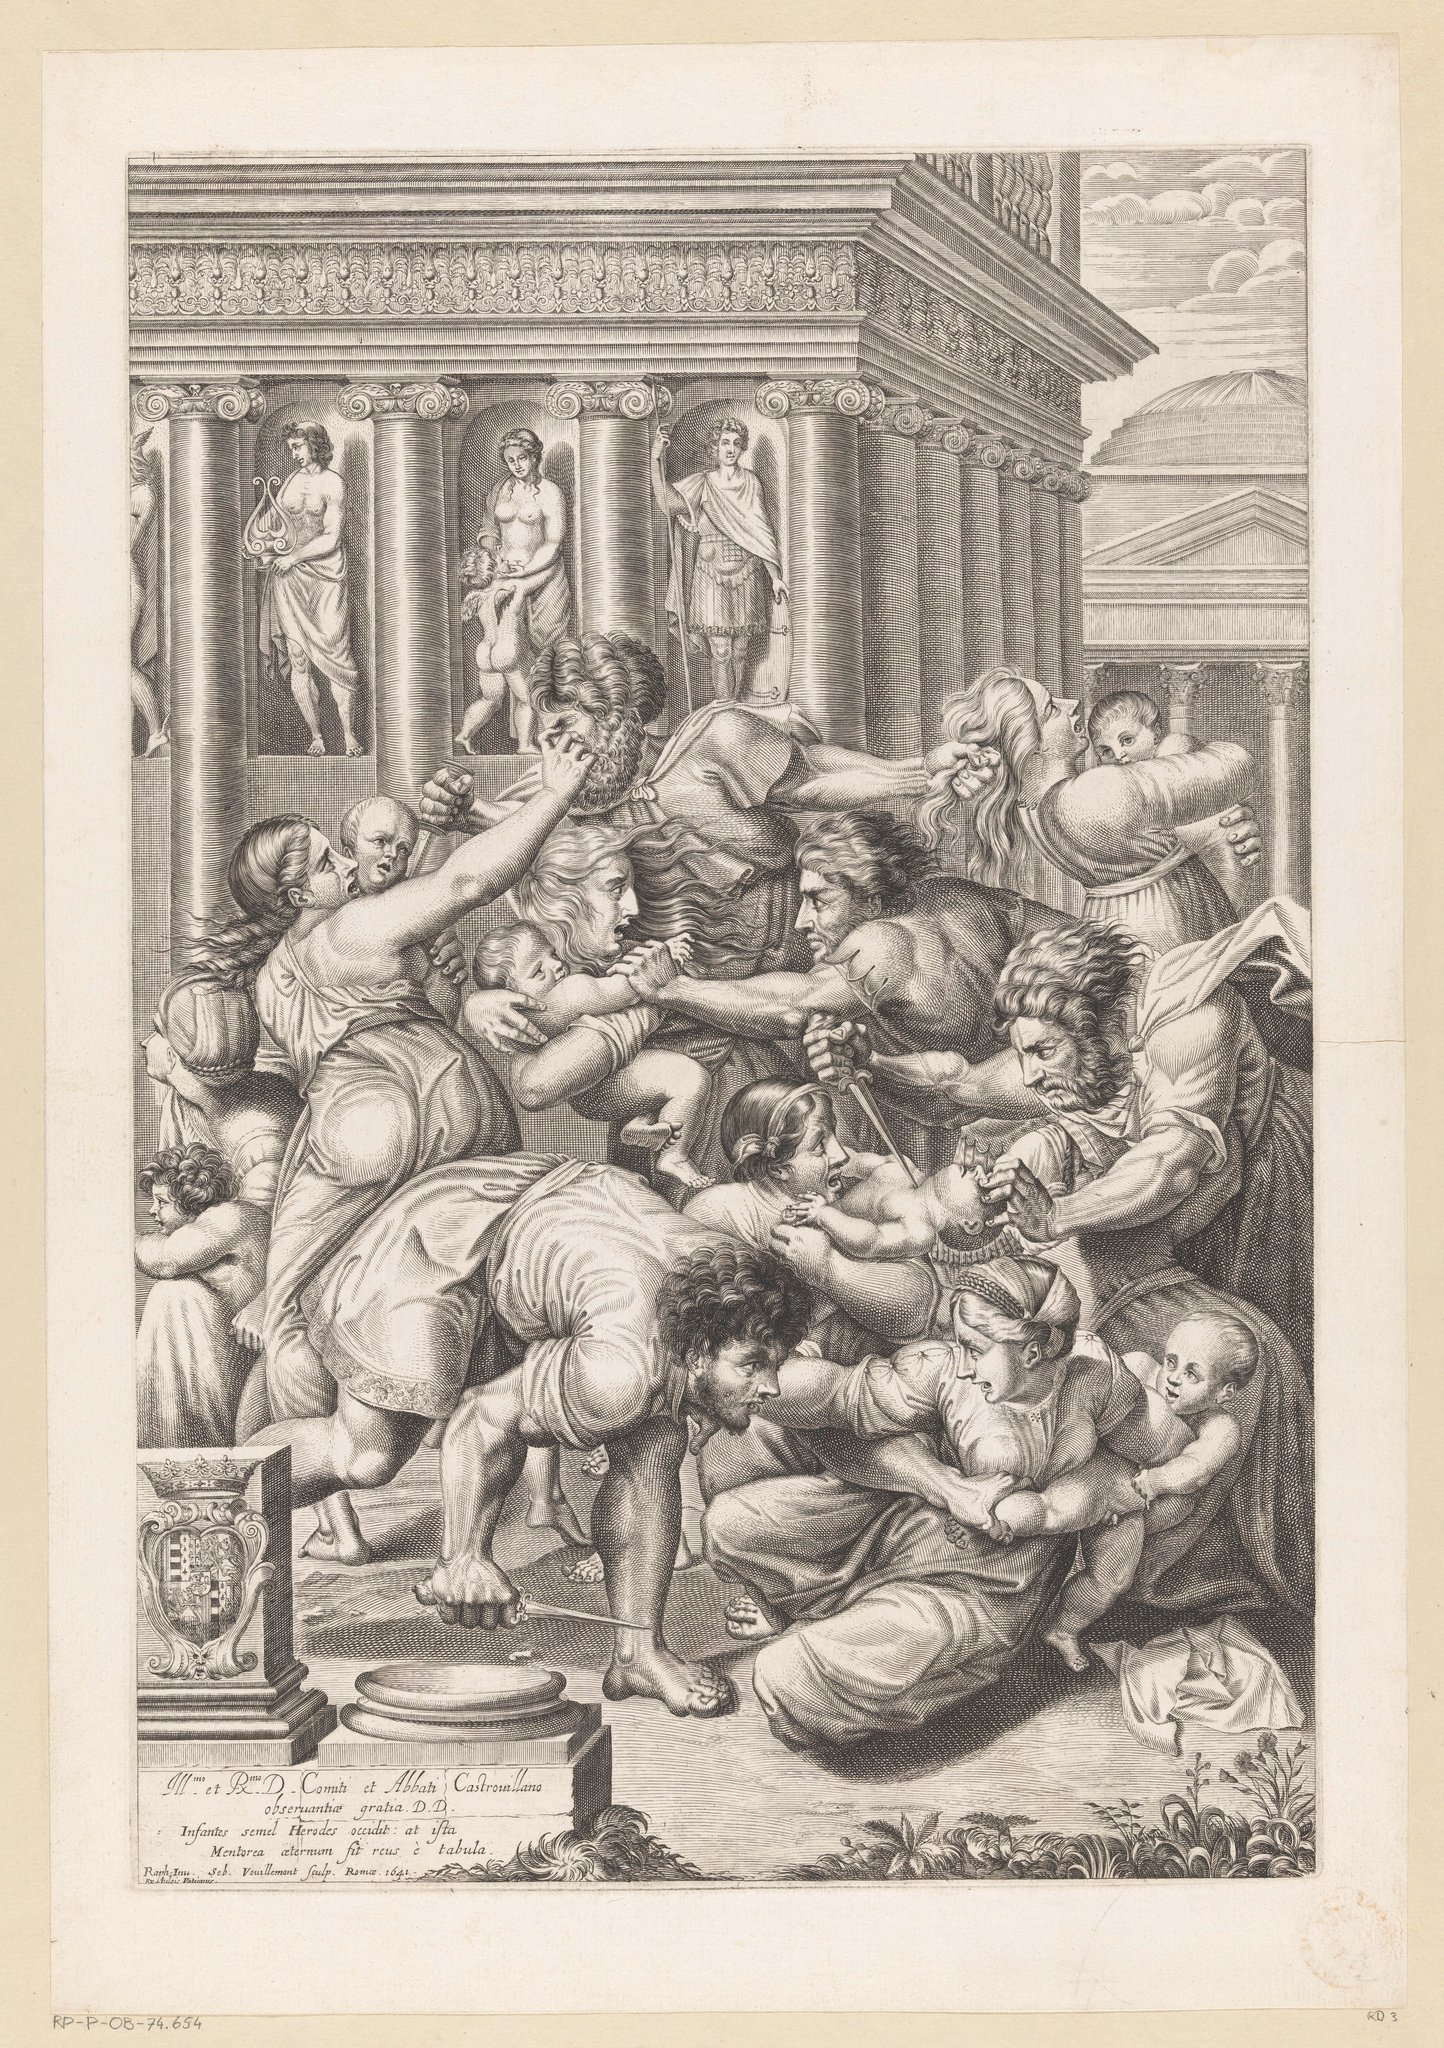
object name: print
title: Kindermoord te Betlehem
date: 1641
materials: paper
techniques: engraving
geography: italy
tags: monument, statue, temple, shrine ~ roman religion, the massacre of the innocents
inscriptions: collector's mark: Lugt 240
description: Ontwerp naar een wandtapijt in de Galleria degli Arazzi in de Vaticaanse Musea.